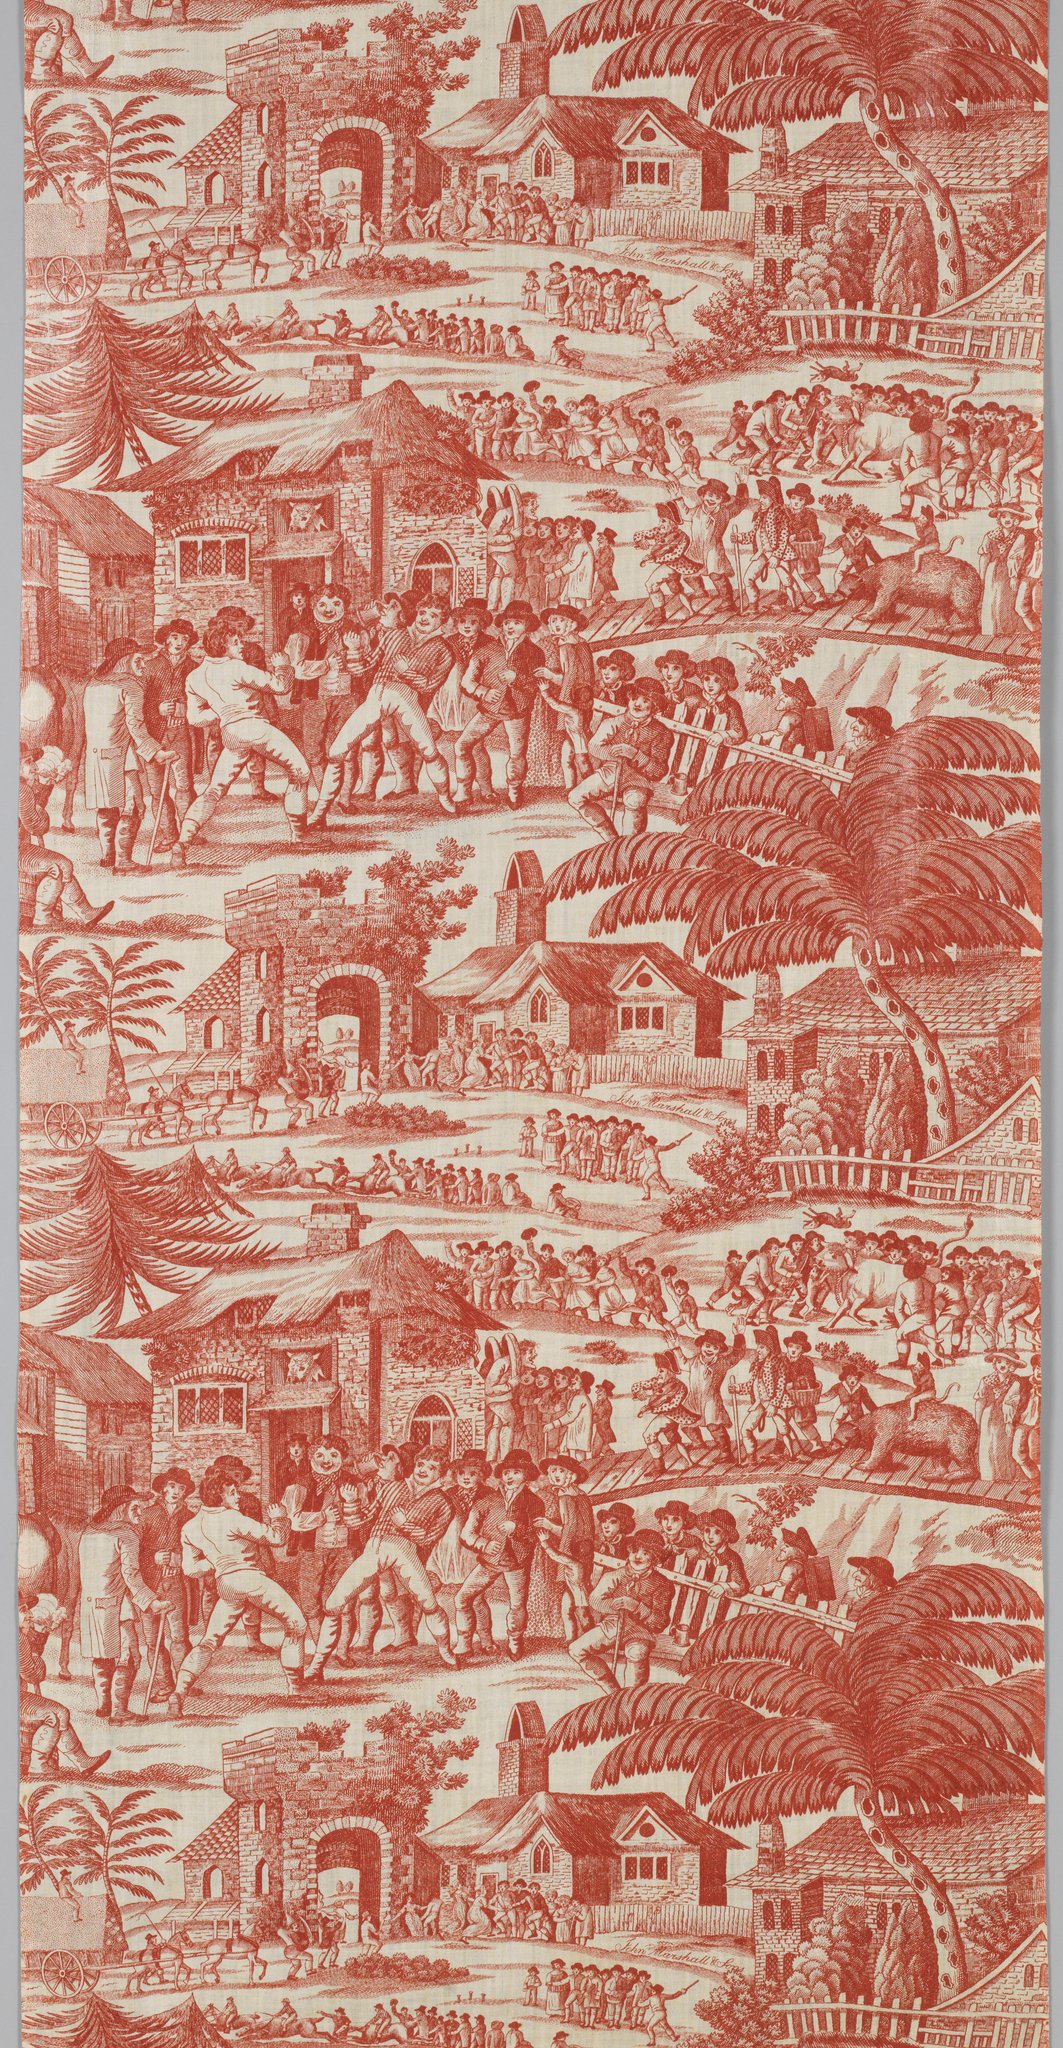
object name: piece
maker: john marshall and sons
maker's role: maker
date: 1801-1833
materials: cotton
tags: houses,trees,crowd